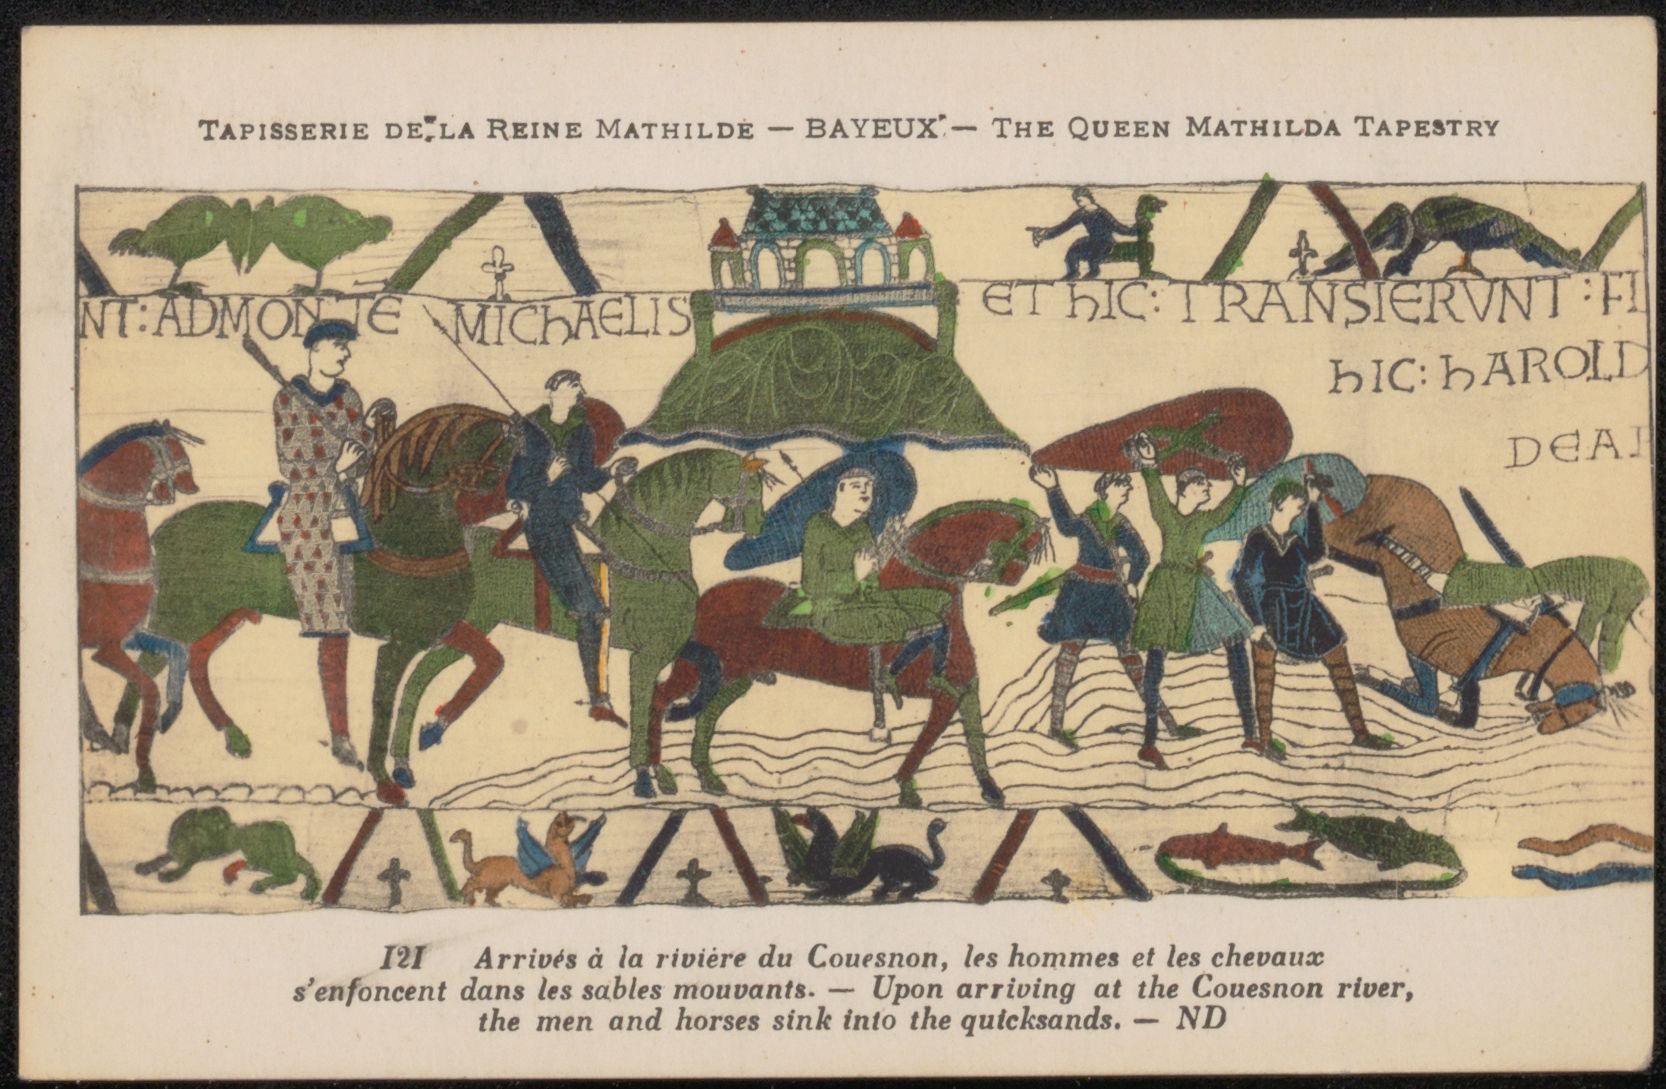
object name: ansichtkaart, prentbriefkaart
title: Prentbriefkaart aan Willem Bogtman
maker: richard nicolaüs roland holst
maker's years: 1868-1938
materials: ink, paper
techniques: photograph, pen, writing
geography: bloemendaal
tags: draughtsman, fik abbing, haarlem, willem bogtman, exhibition ~ art